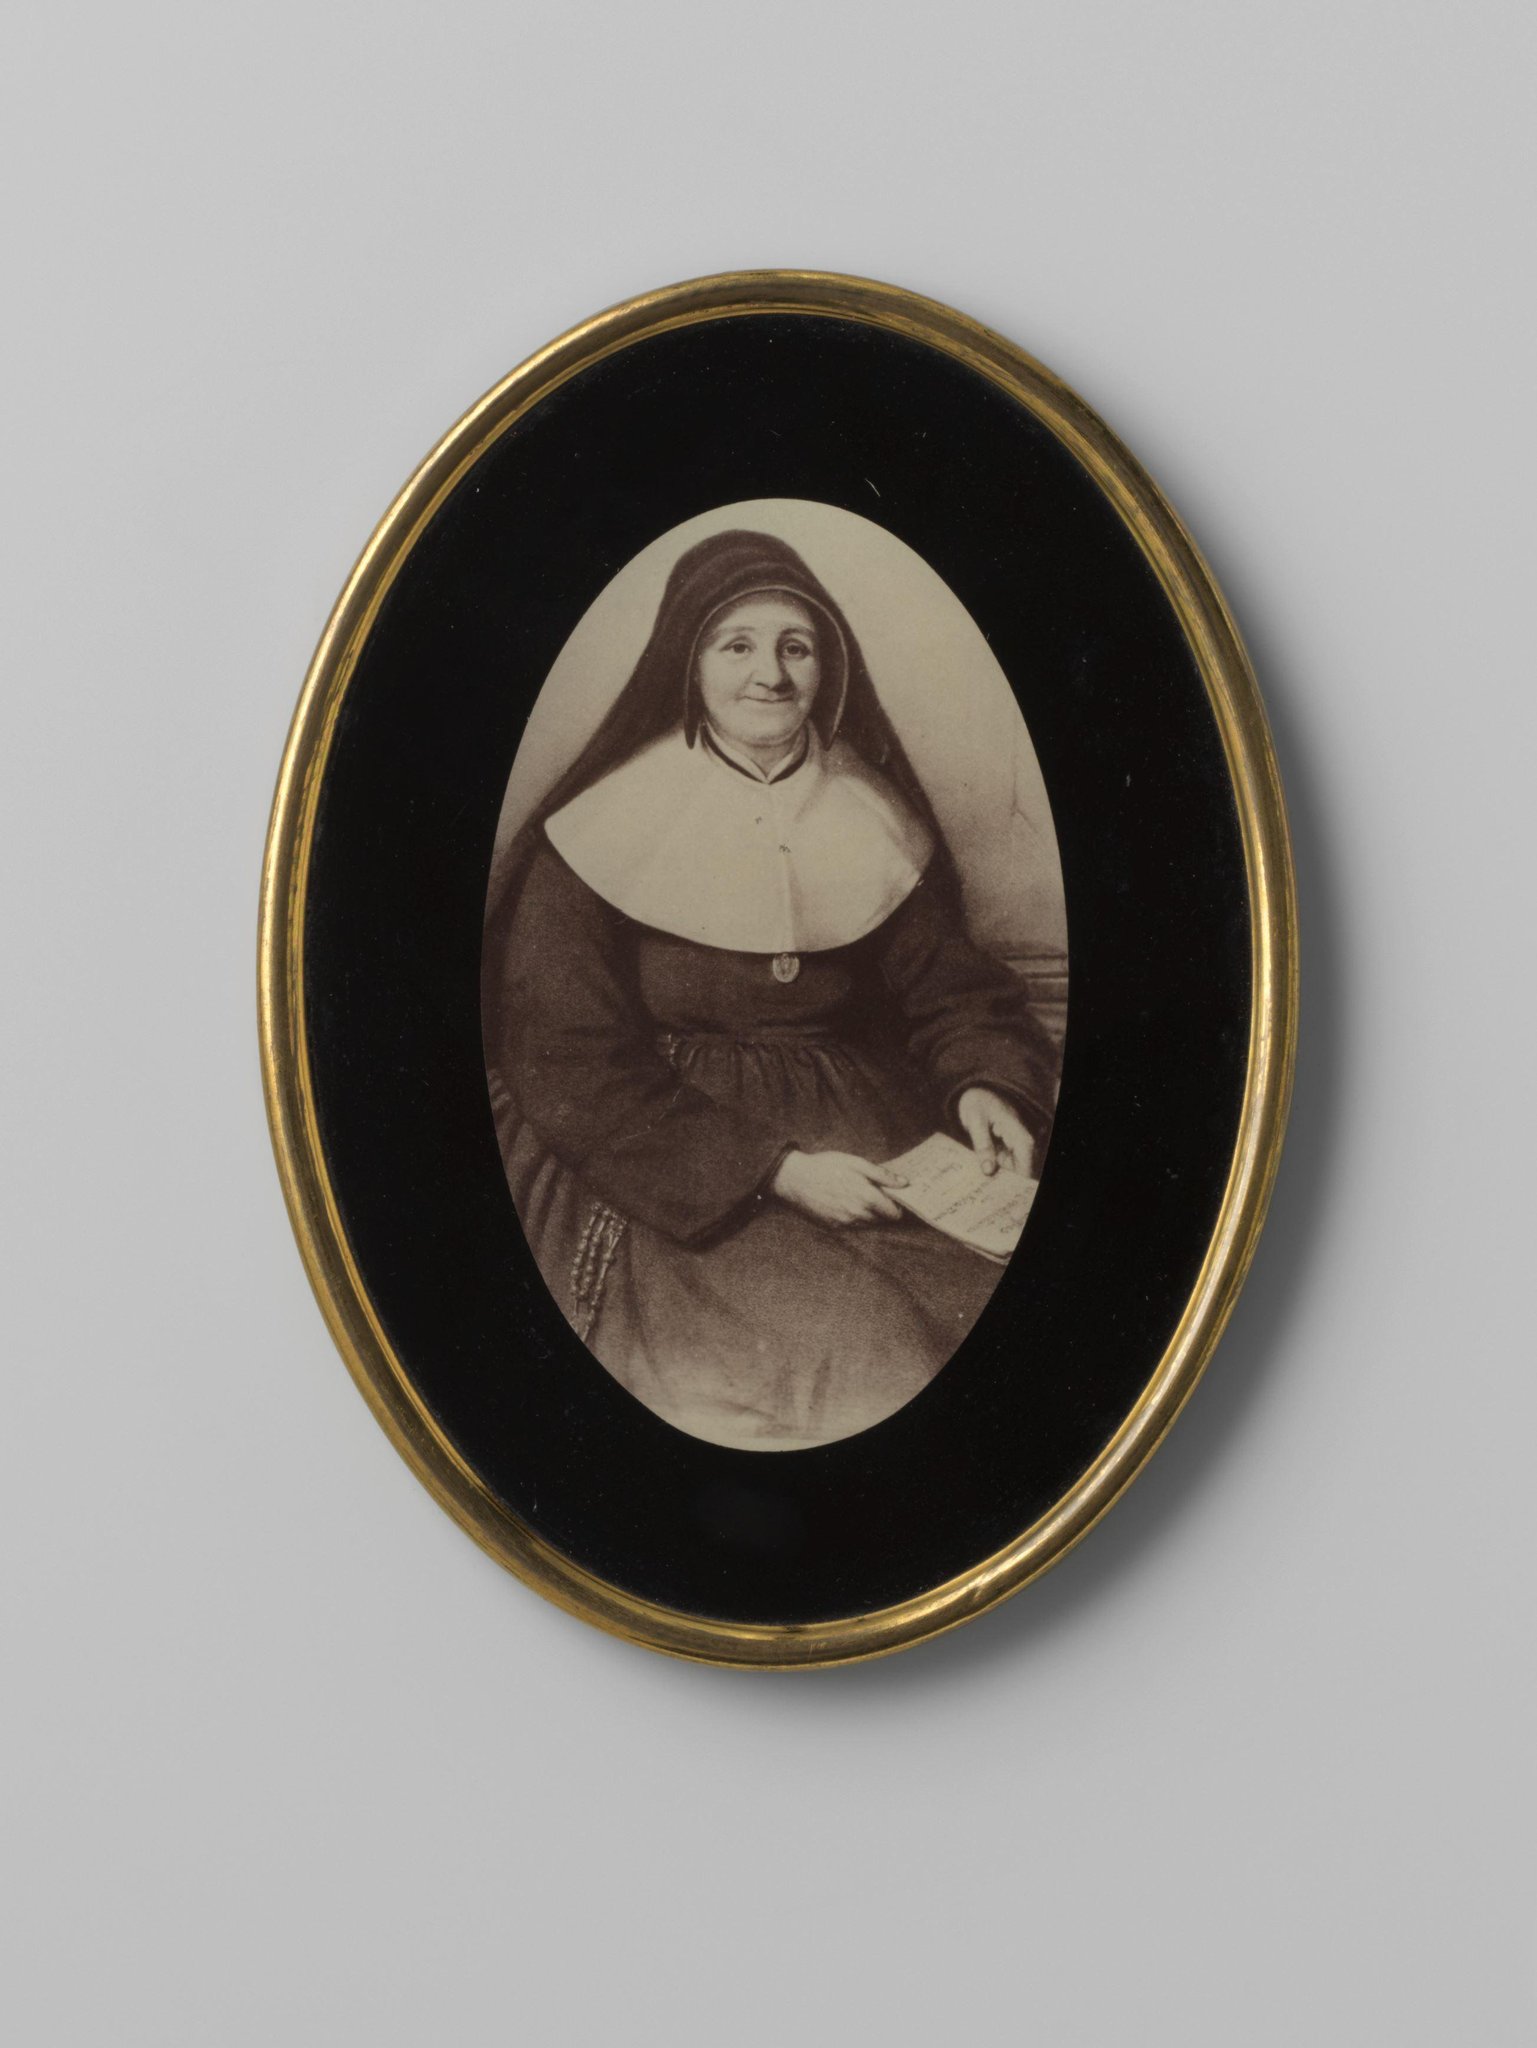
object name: photograph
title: Fotoreproductie van een getekend portret van een onbekende vrouw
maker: Anonymous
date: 1880-1900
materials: cardboard, glass, metal, paper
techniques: albumen print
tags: adult woman, anonymous historical person portrayed